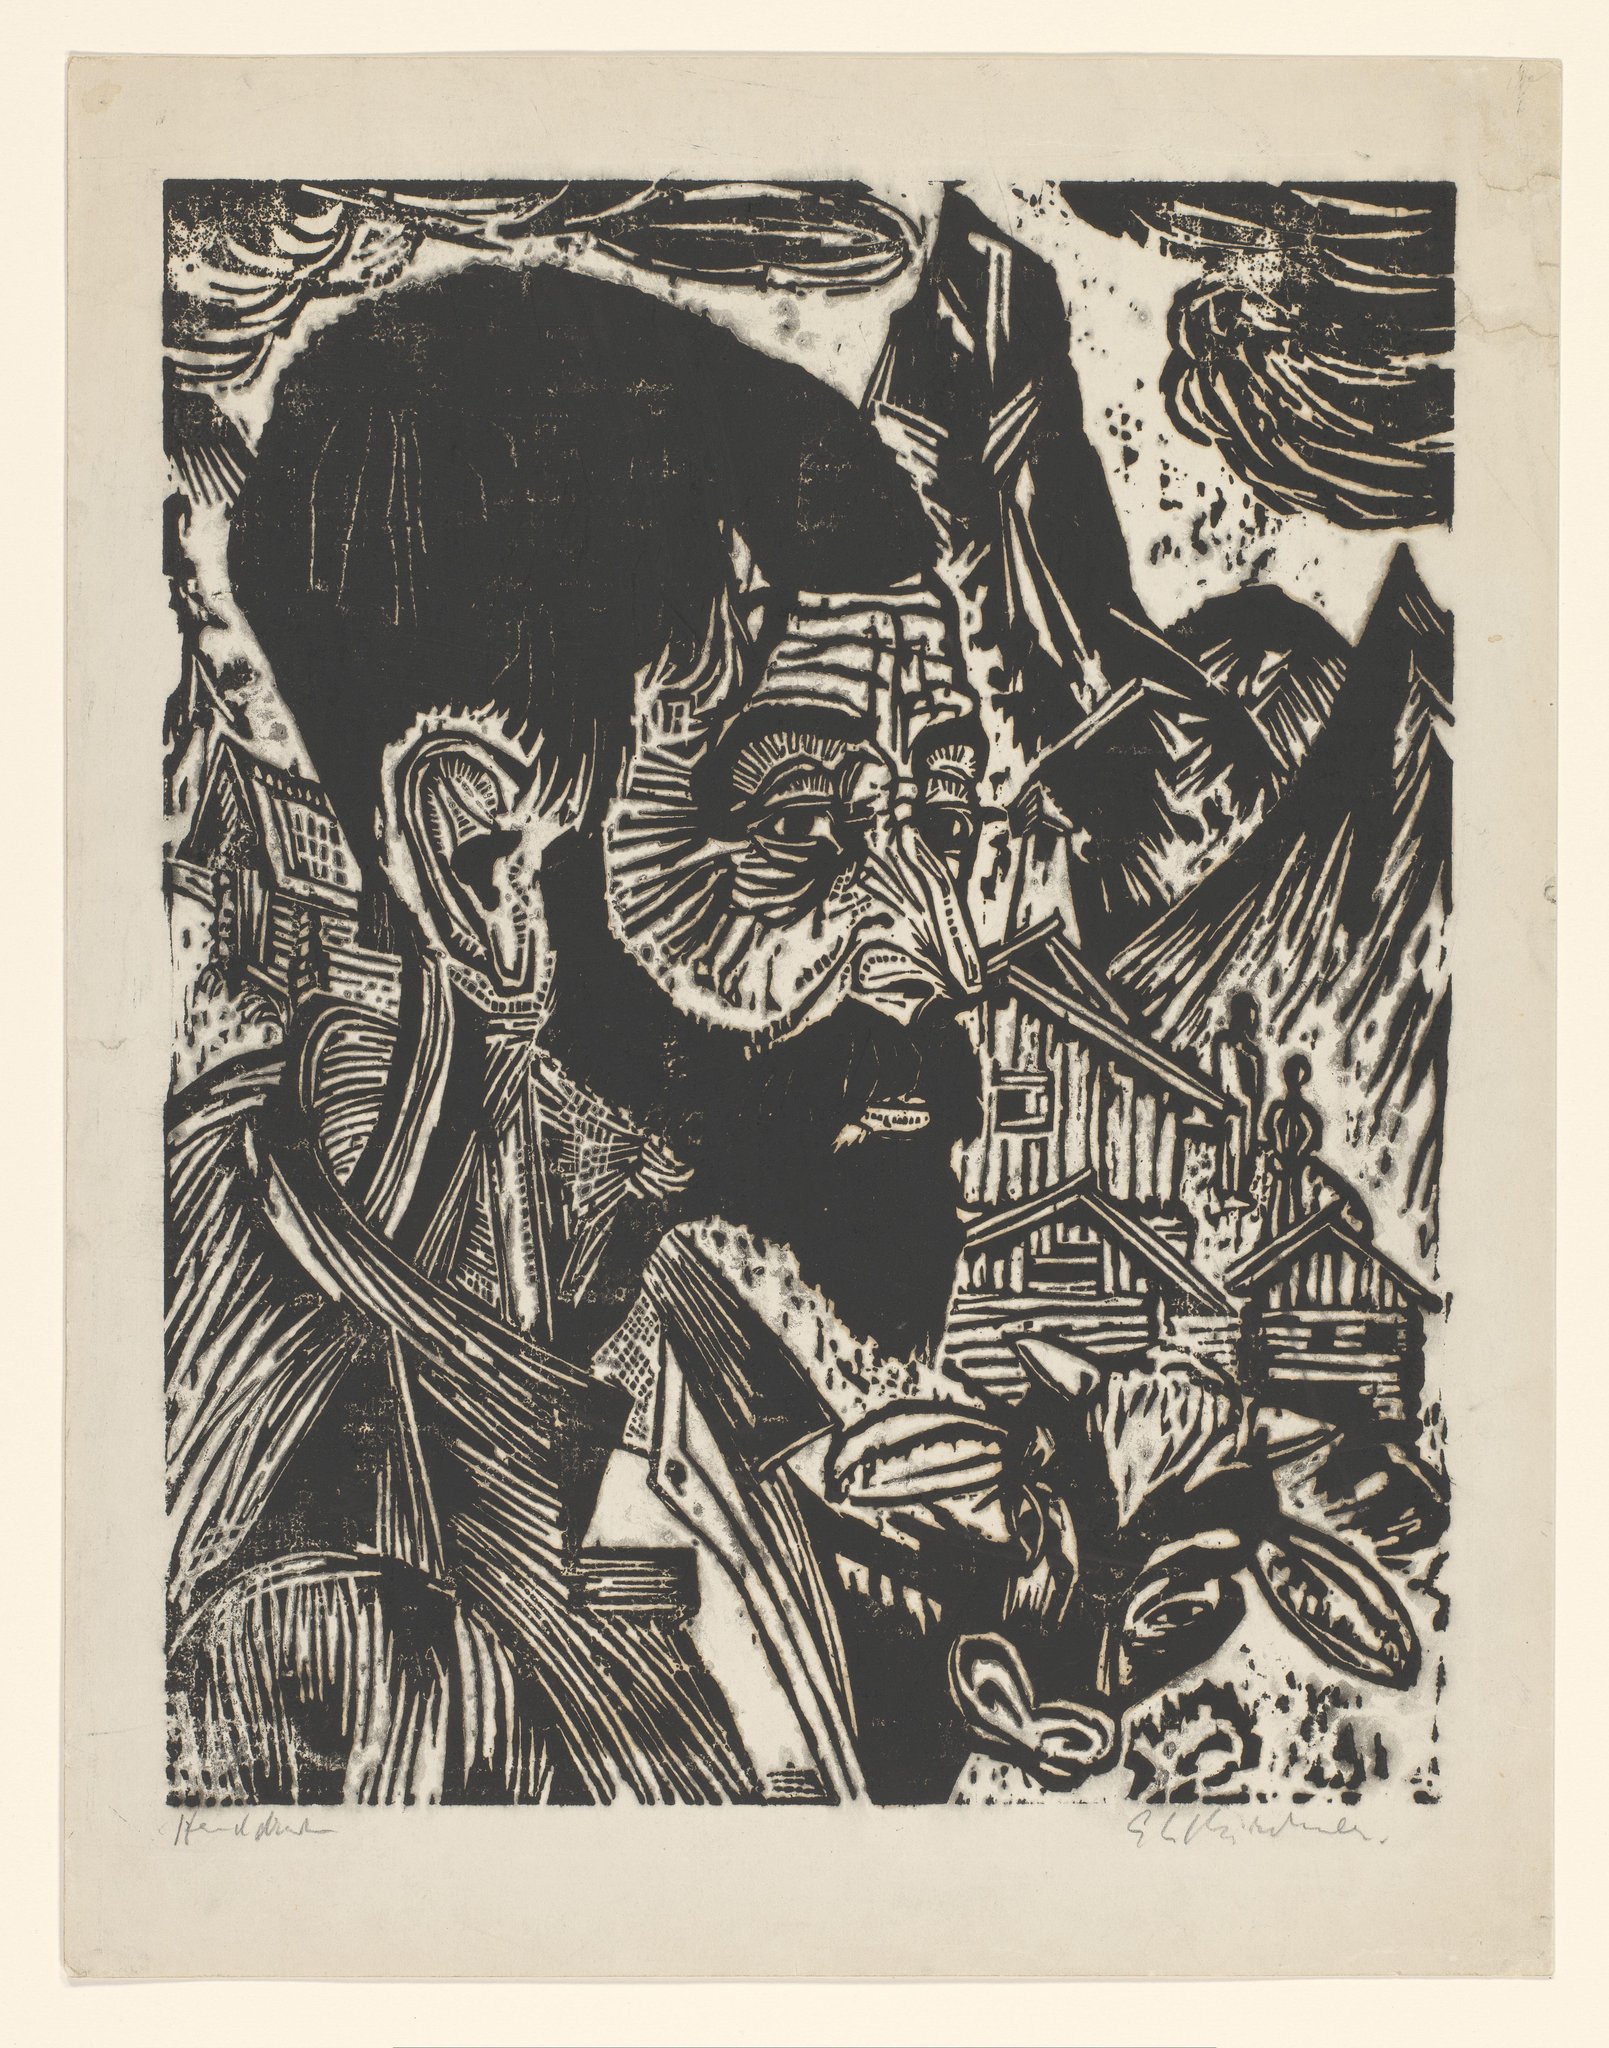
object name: print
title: Sennkopf (Martin Schmied)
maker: ernst ludwig kirchner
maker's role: print maker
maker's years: 1880-1938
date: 1917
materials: paper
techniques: woodcut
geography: germany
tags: historical persons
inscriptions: annotation: ‘Handdruck (?)’, collector's mark: Lugt 2228, annotation: ‘9 cm Autotypie Kopf Schmidt’, collector's mark: Lugt 2760